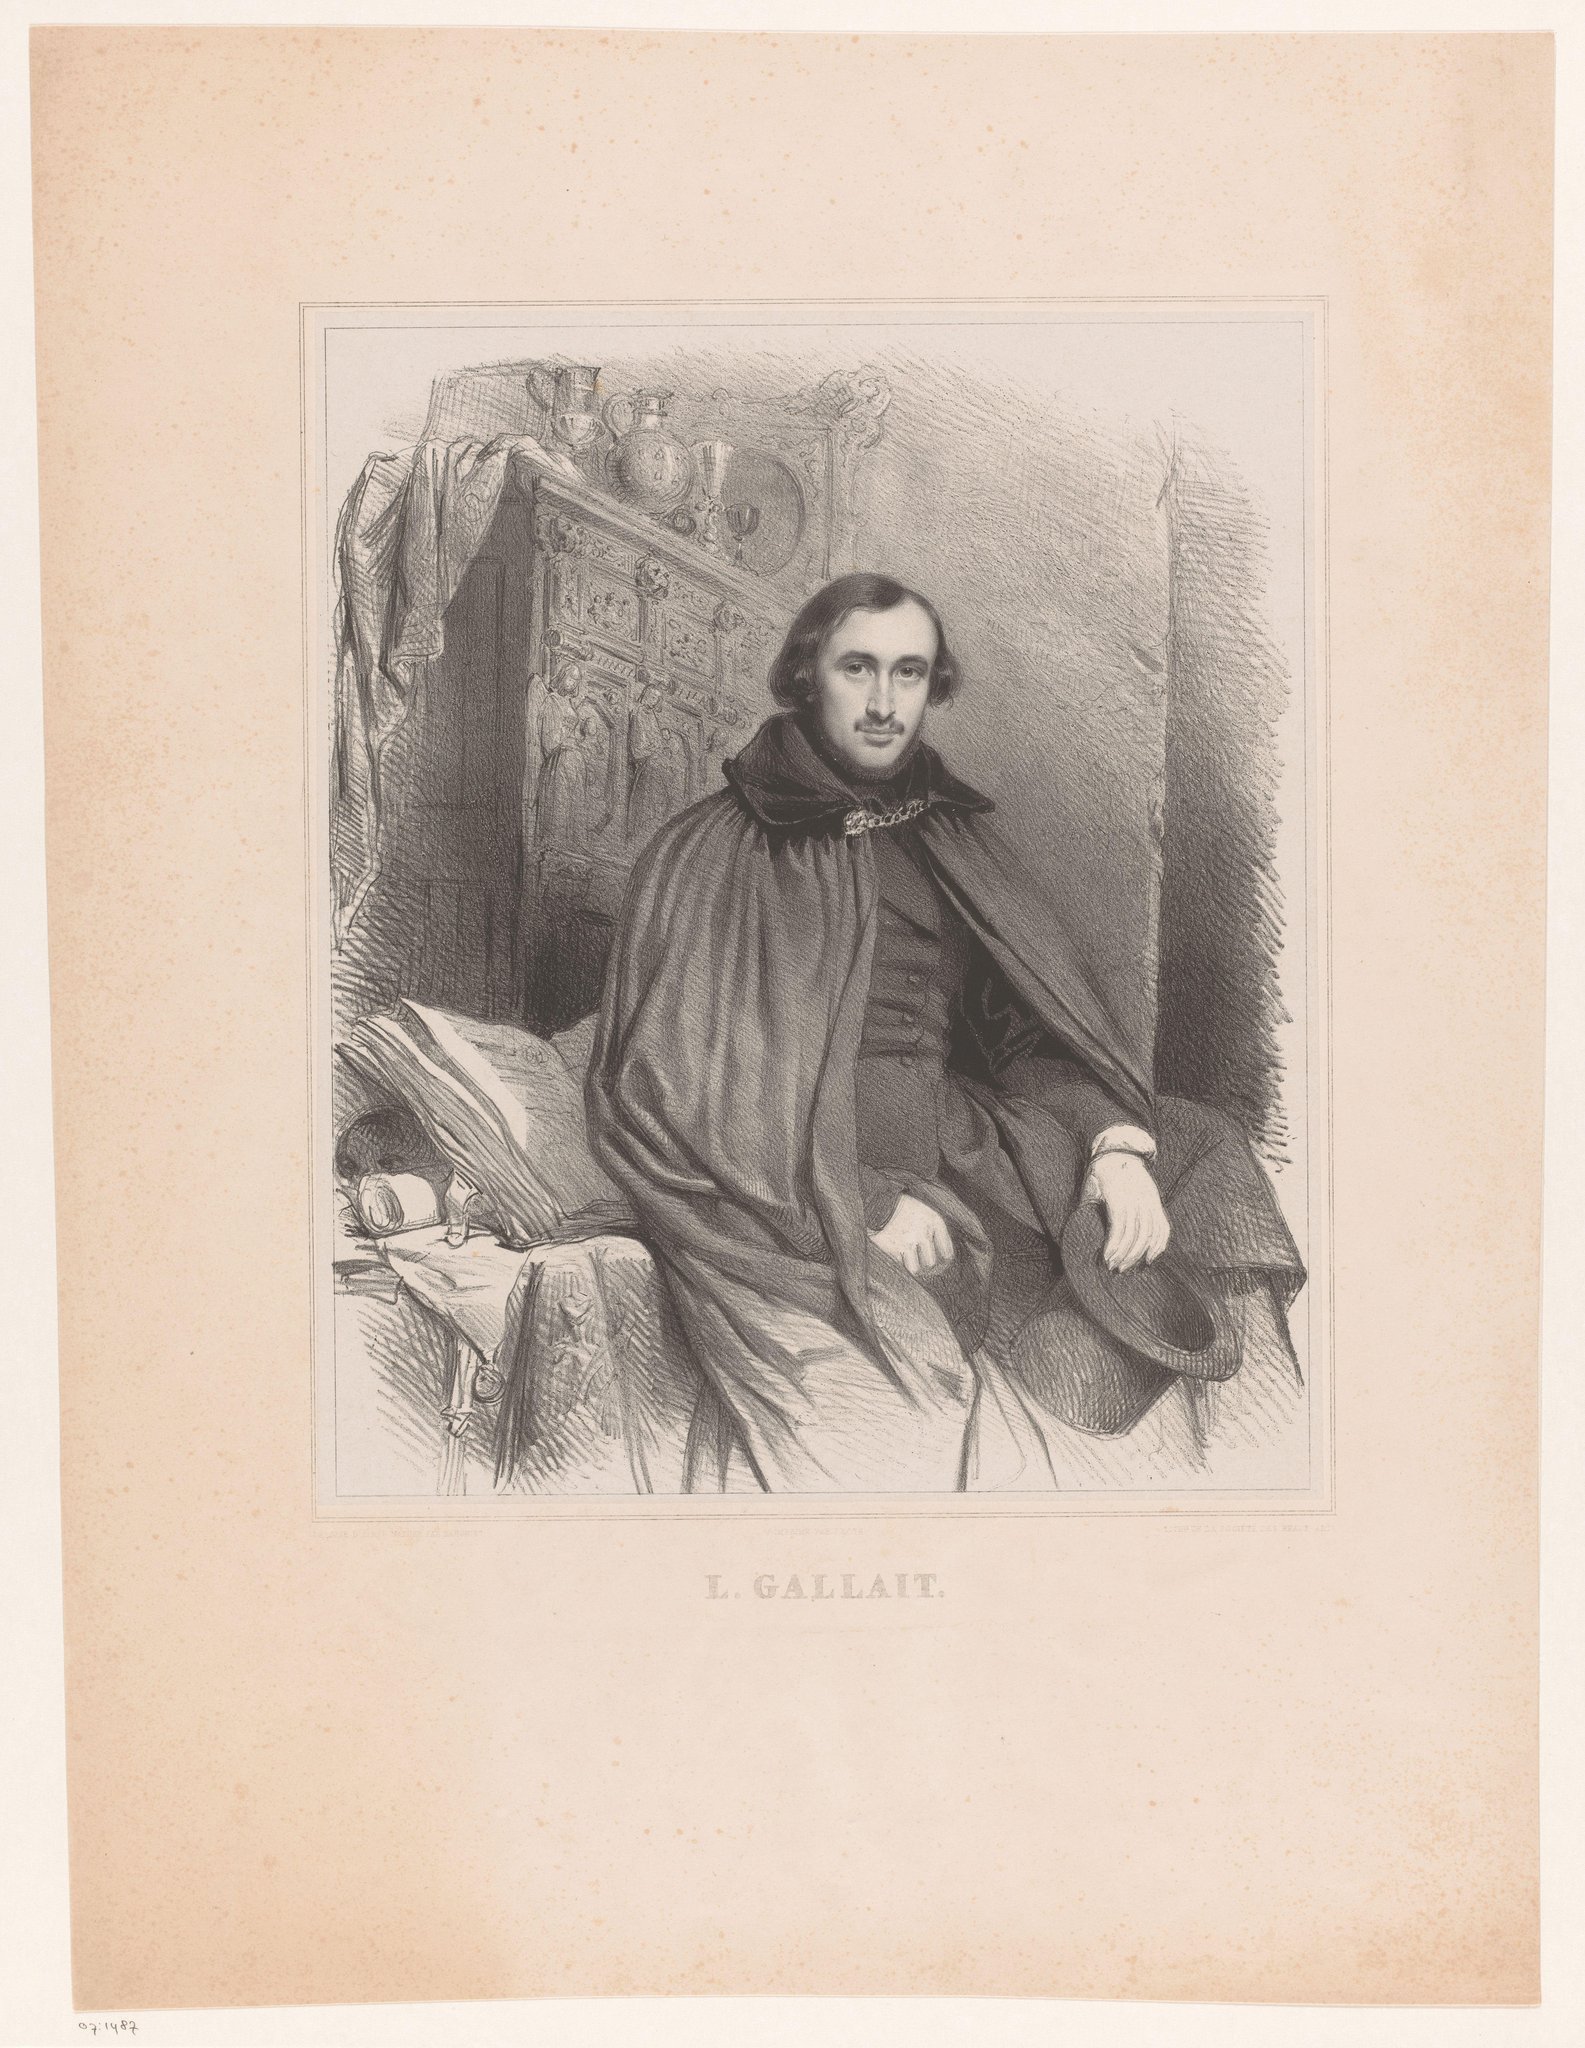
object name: print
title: Portret van Louis Gallait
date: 1836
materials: paper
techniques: lithograph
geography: brussels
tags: draughtsman, louis gallait, adult man, historical persons, book - mm - book open, interior of the house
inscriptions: collector's mark: Lugt 2228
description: Andere staat verschenen in: Baugniet, Charles. Les artistes contemporains: portraits lithographiés d'après nature, accompagnés de notices sur la vie et les ouvrages de chacun d'eux. Brussel: De Wasme-Pletinckx, [1836-1840].